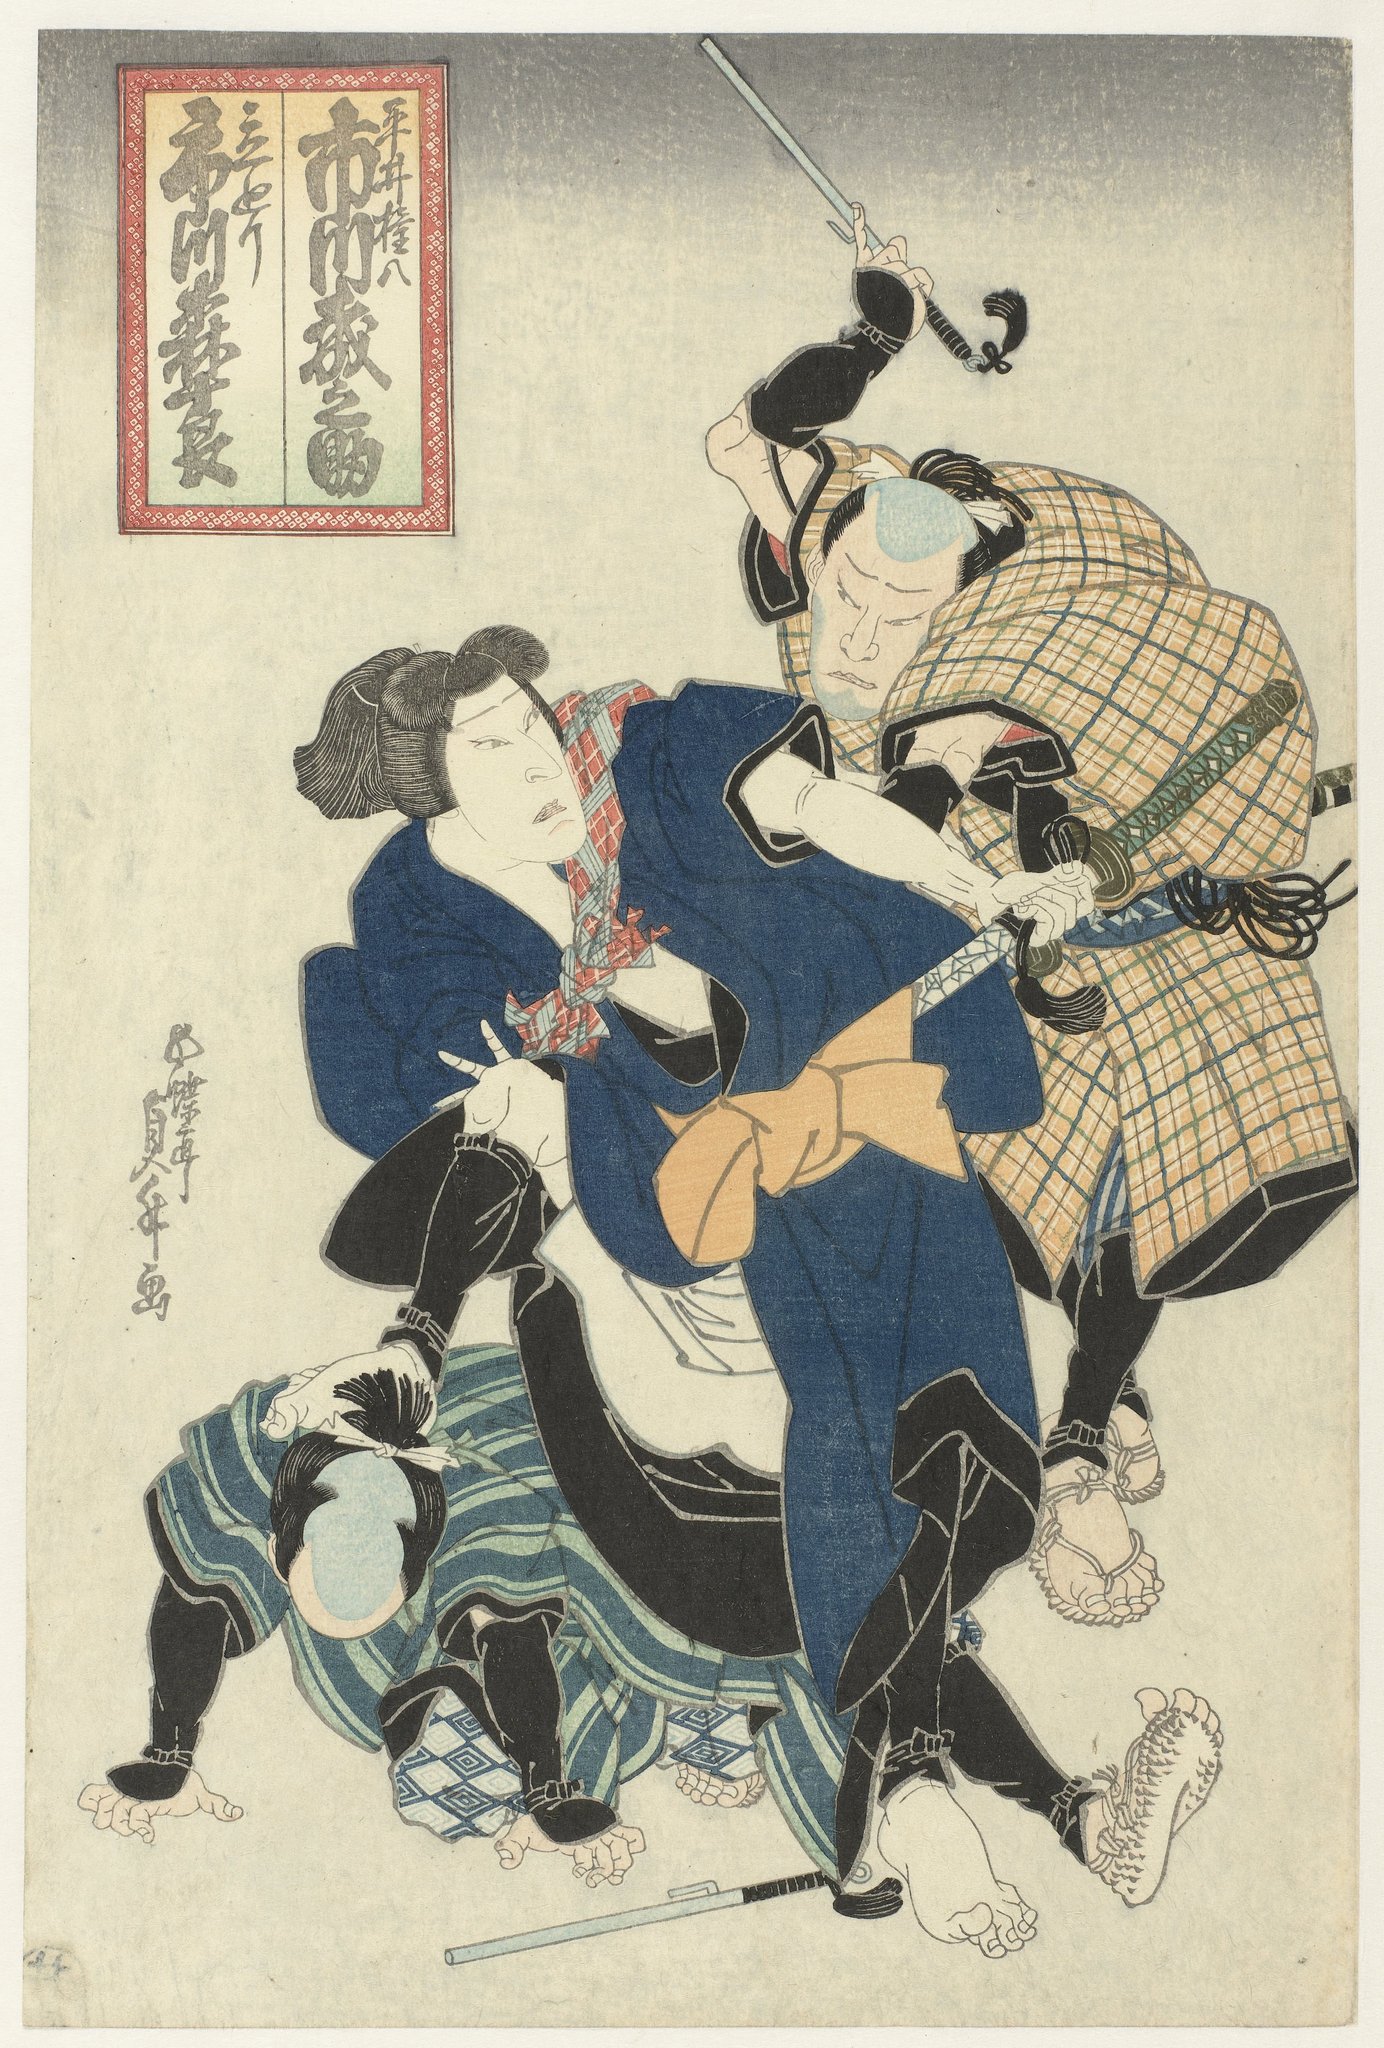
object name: print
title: Tachimawari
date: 1801-1839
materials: paper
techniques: woodcut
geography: osaka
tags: adult man (+ three persons), weapons, fighting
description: Drie vechtende mannen. Ichikawa Morinosuke II, in blauwe kimono, in de rol van Shirai Gonpachi, wordt door twee mannen aangevallen. De man in gele kimono en stok boven zijn hoofd, wordt gespeeld door Ichikawa Morijûrô. De derde acteur (op de grond) is onbekend. De scène komt uit het toneelstuk ‘Shirai Gonpachi Yoshiwara gayoi’, opgevoerd in het Ônishi theater in de eerste maand van 1839.